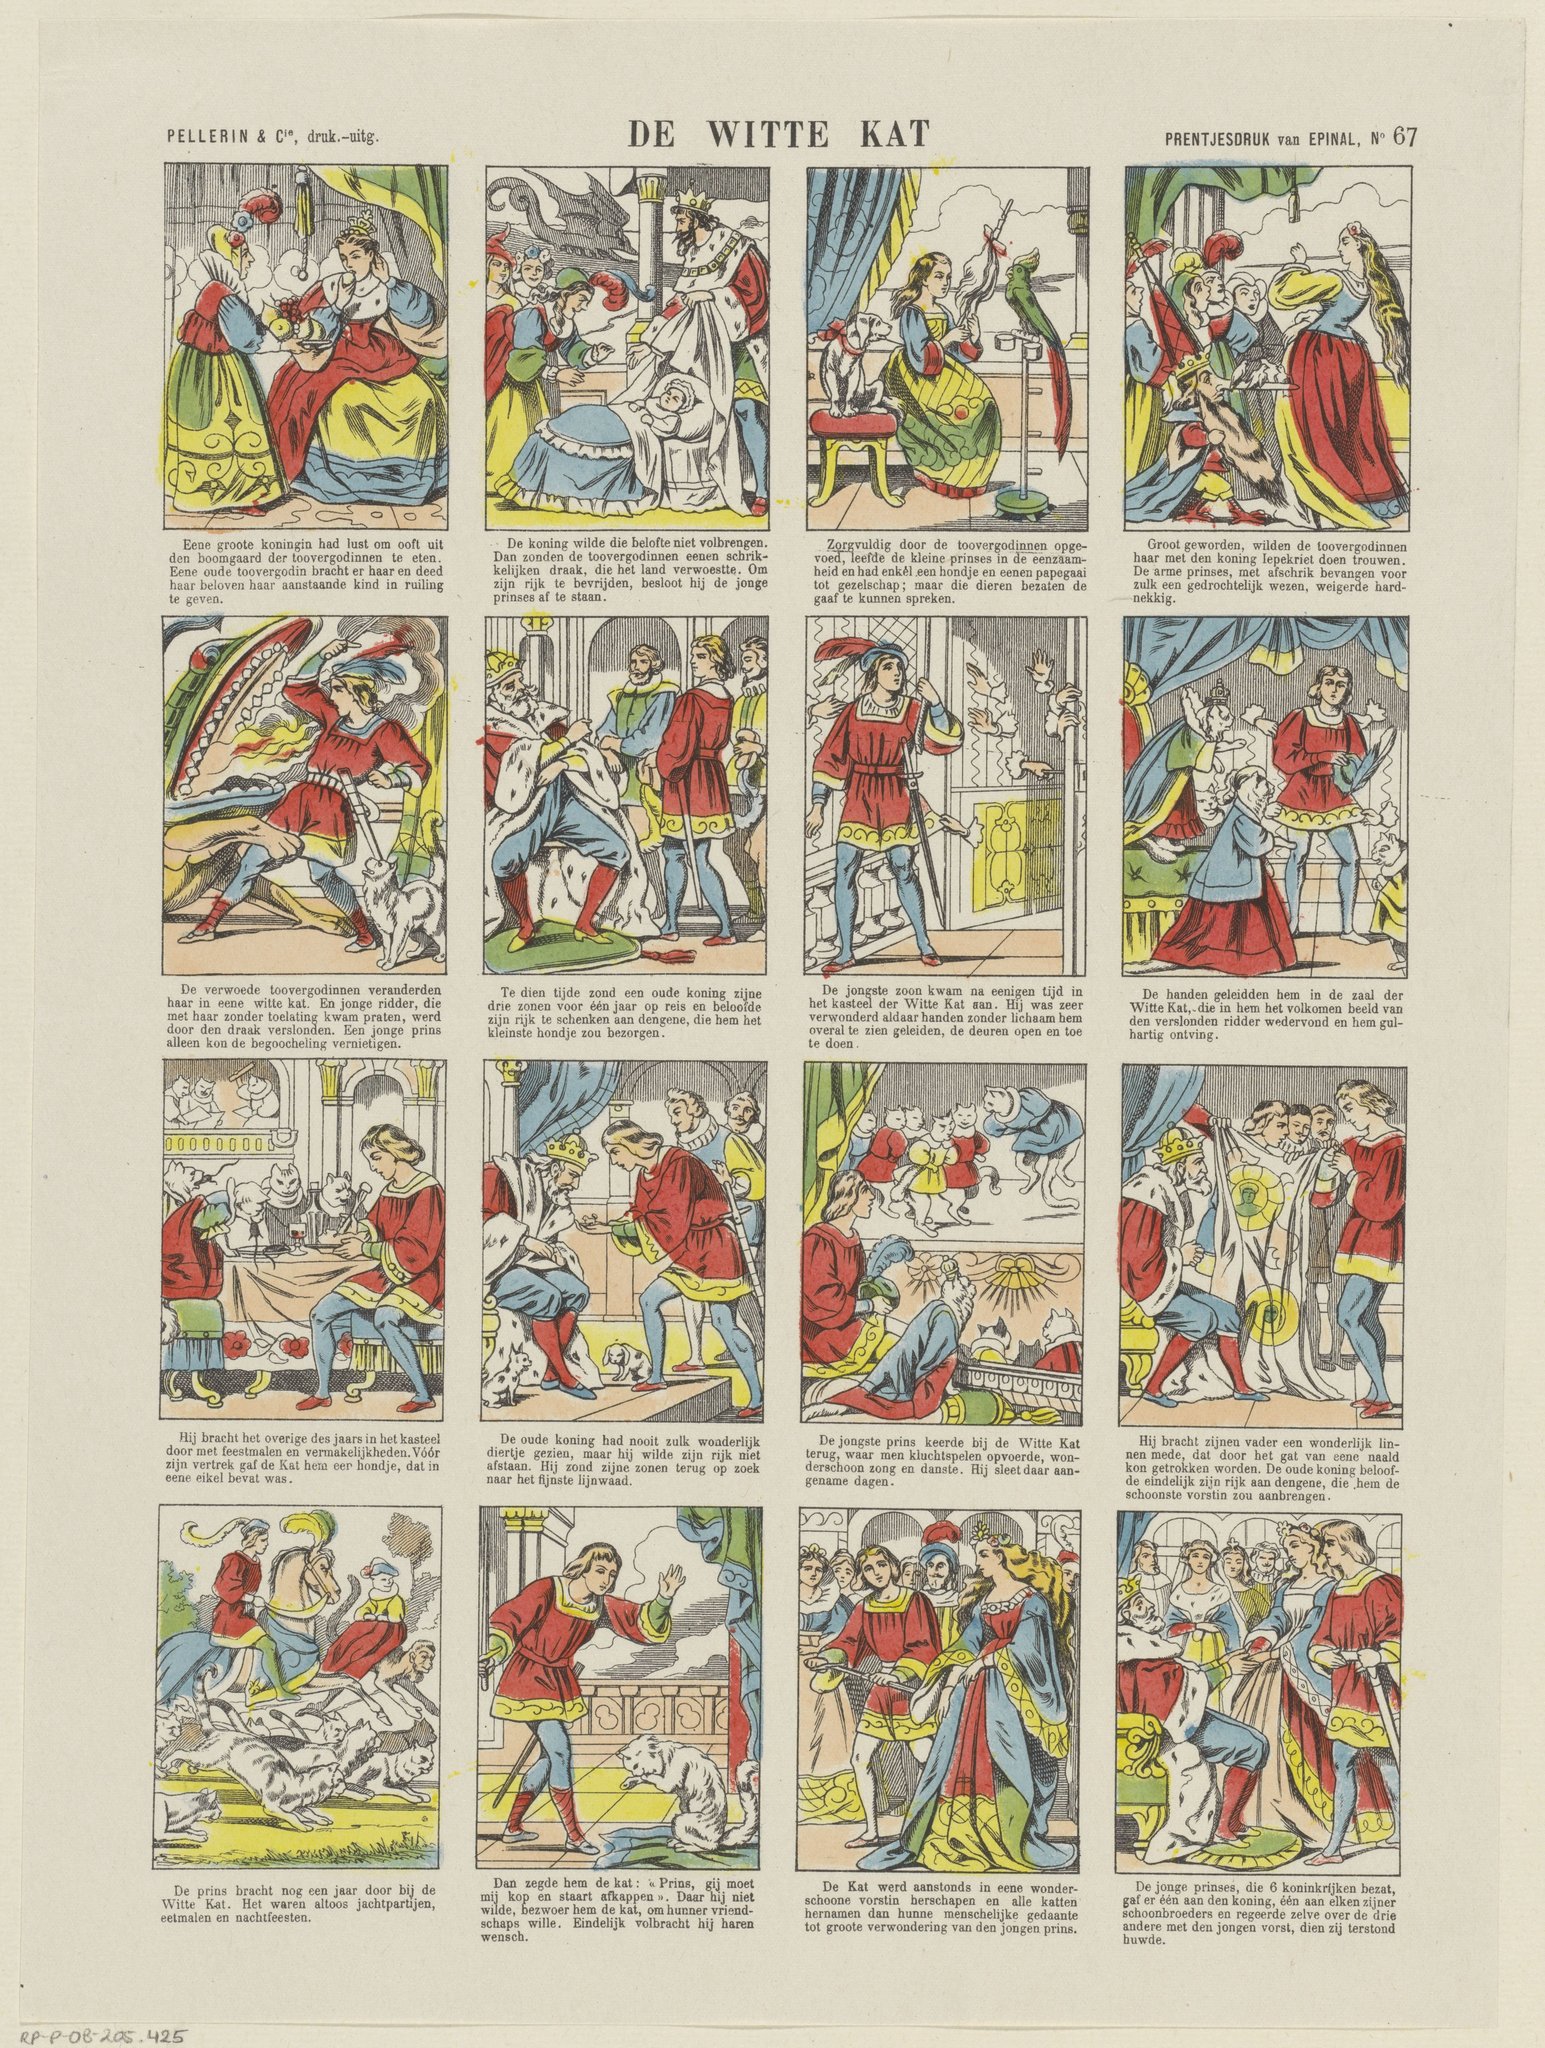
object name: popular print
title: De witte kat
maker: Anonymous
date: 1902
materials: paper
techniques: colour, letterpress printing, lithograph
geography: epinal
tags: cat, transformation, metamorphosis of person, prince, princess, tales and fairy tales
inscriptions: collector's mark: Lugt 2760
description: Blad met 16 voorstellingen uit het verhaal van de witte kat die in een prinses verandert. Onder elke afbeelding een onderschrift. Genummerd rechtsboven: No 67.